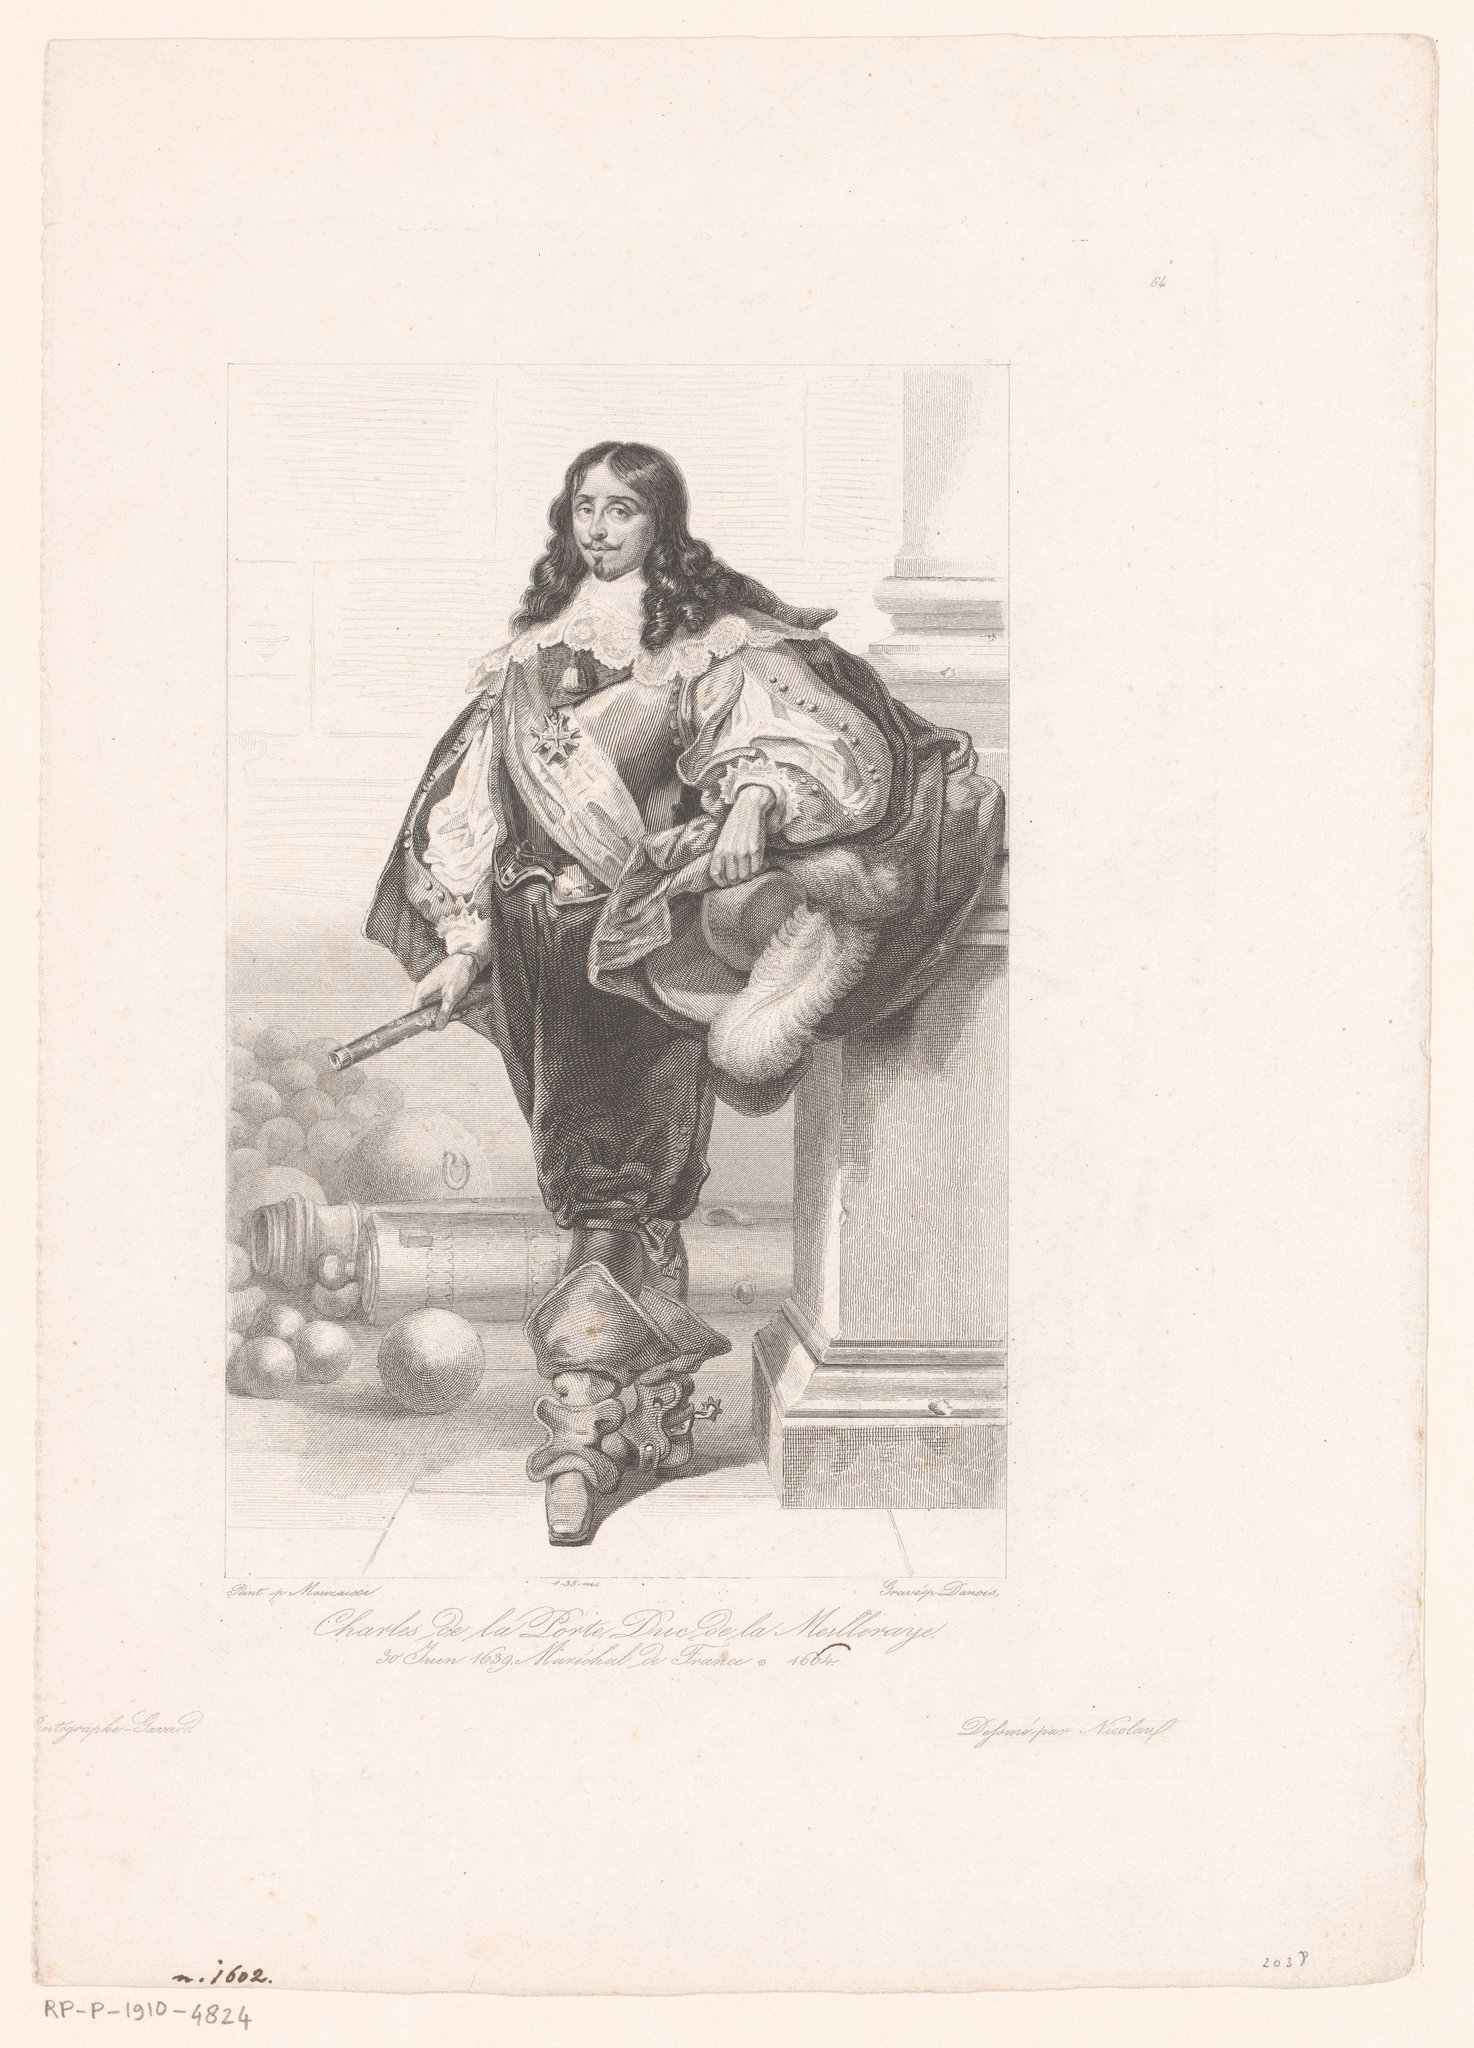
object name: print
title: Charles de la Porte, duc de la Meilleraye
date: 1838-1841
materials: paper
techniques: engraving, etching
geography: france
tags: paris, charles de la porte, historical persons, firearms: cannon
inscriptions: collector's mark: Lugt 2228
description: Prent uit: s.n. Galeries historiques de Versailles. Parijs: Charles Gavard, 1838-1841, p. 109.